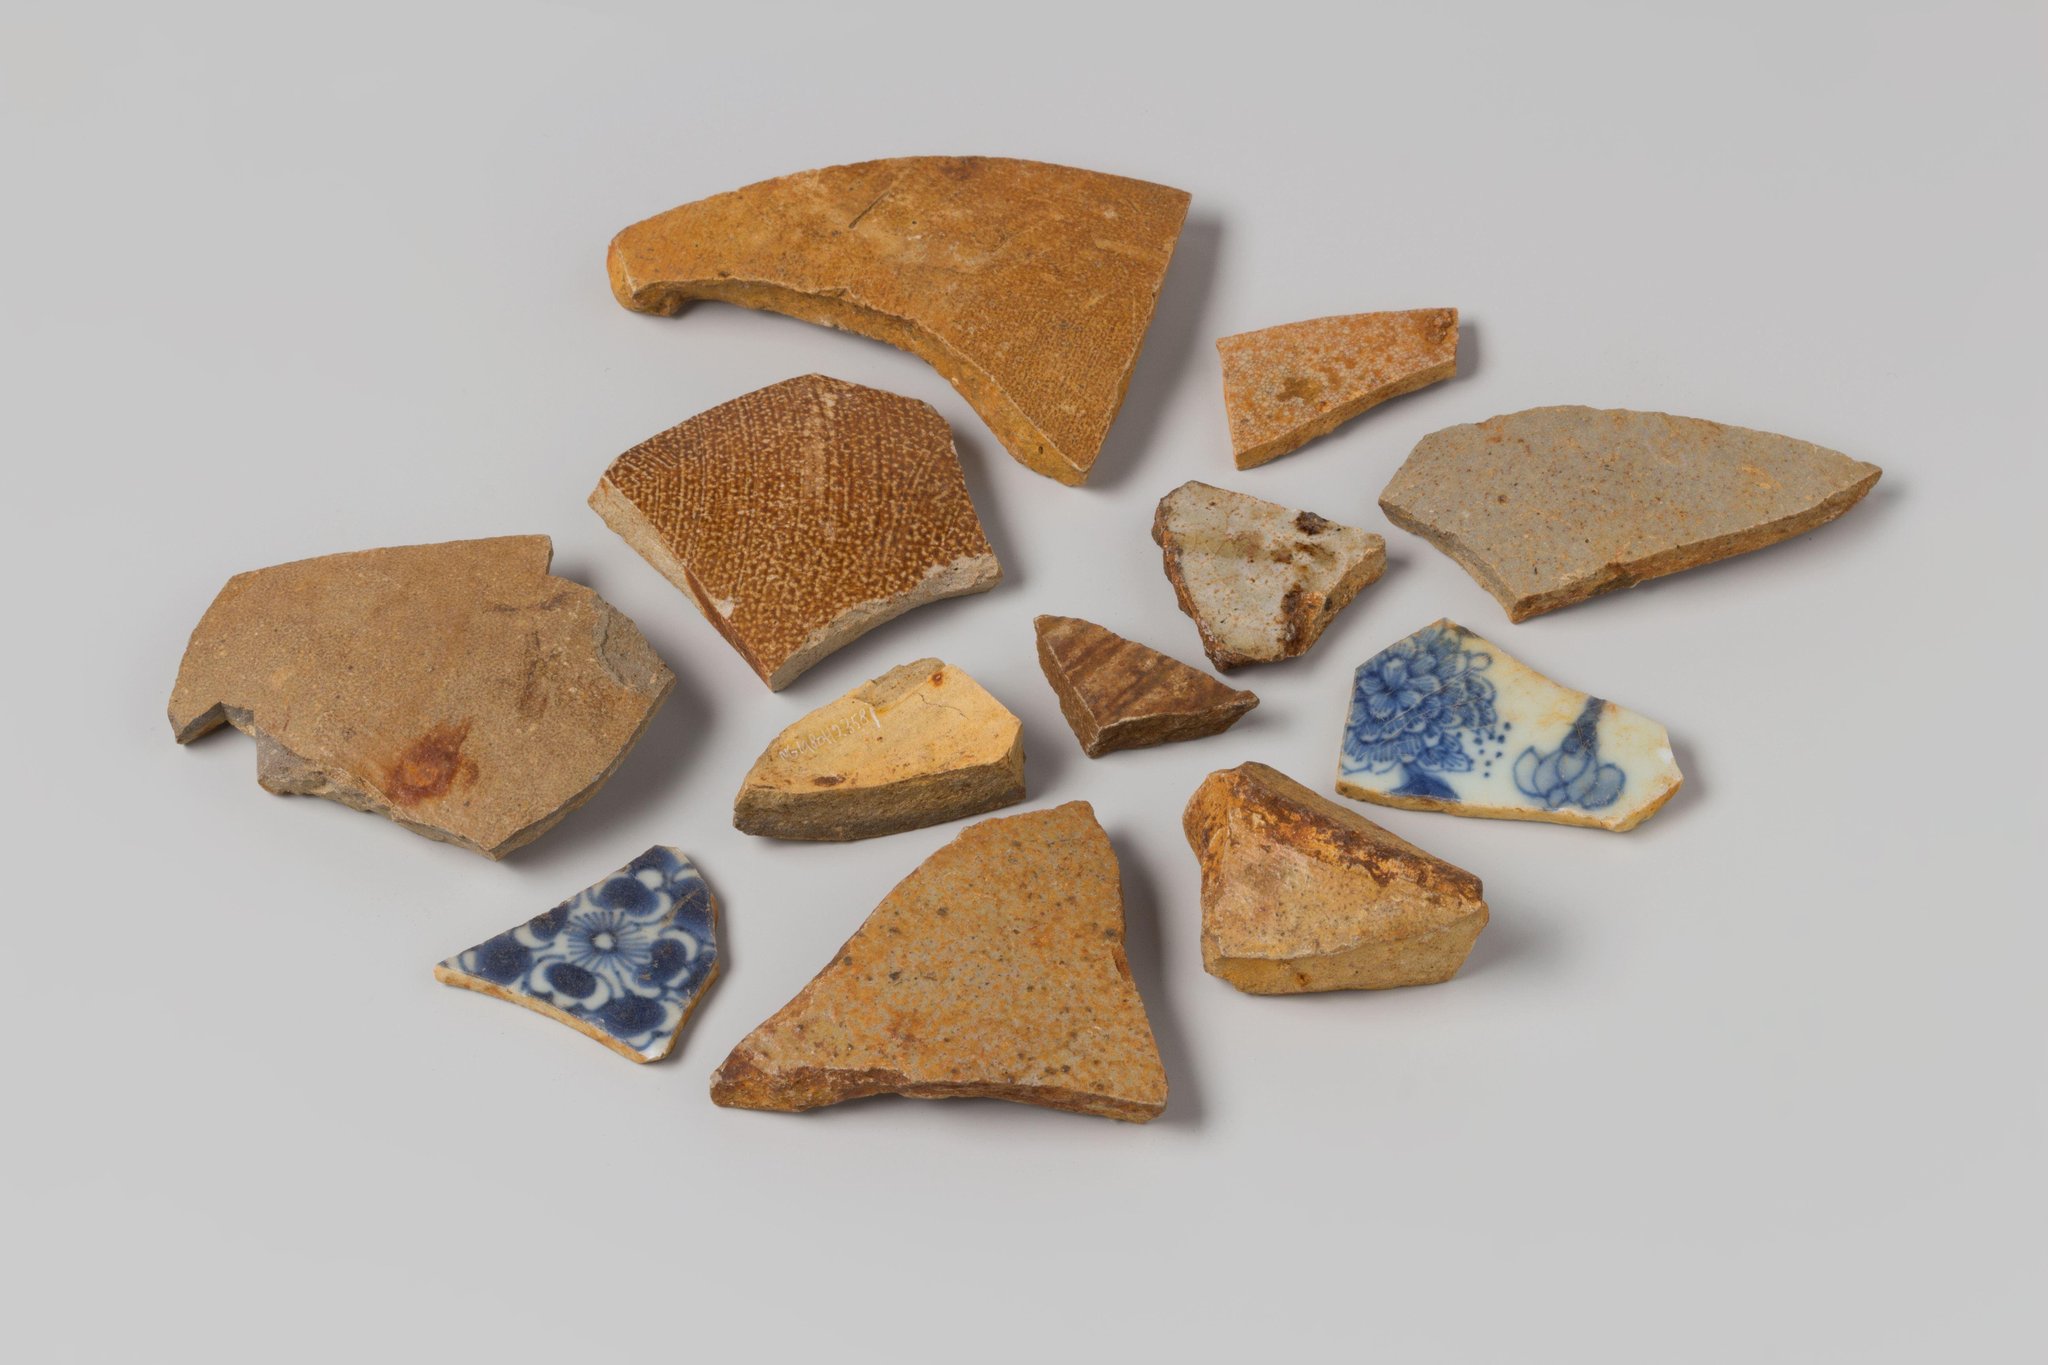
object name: ewer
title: Scherven van kannen en porselein uit het wrak van de Oost-Indiëvaarder Hollandia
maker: Anonymous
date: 1700-1743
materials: porcelain, stoneware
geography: cologne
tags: verenigde oostindische compagnie, hollandia (schip), annet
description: Stoneware, Rhenish, Frechen-ware, jug; fragm of bodies.